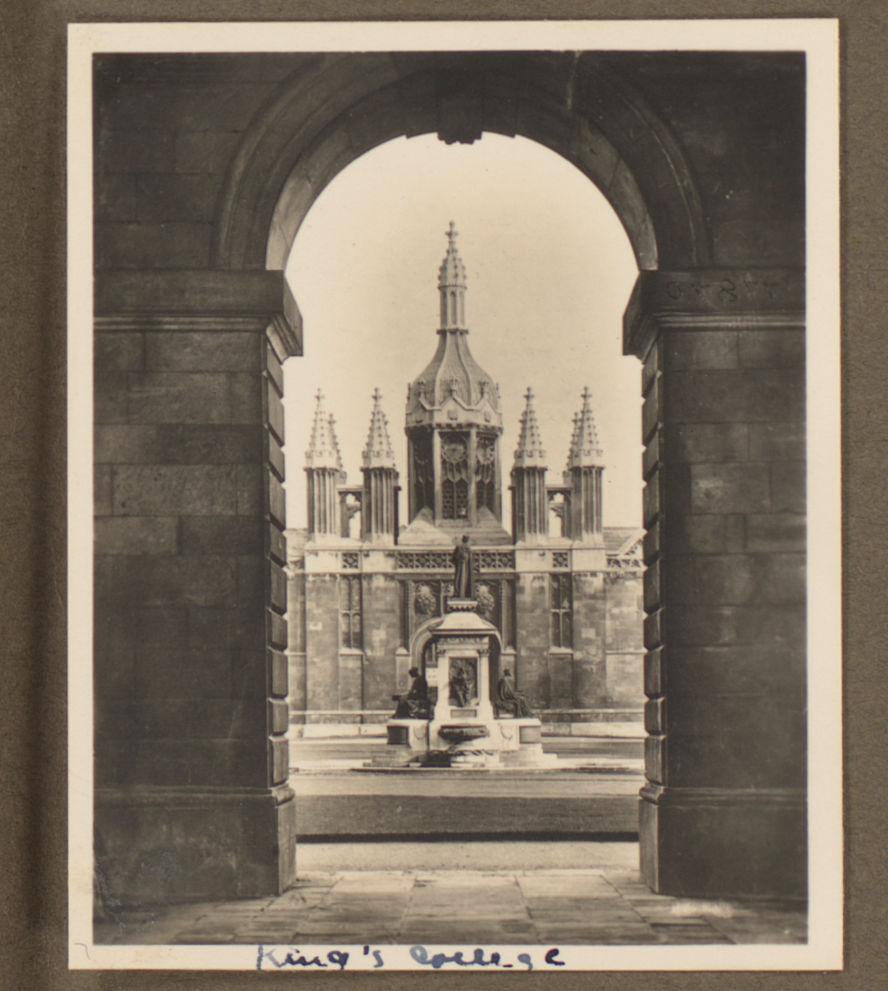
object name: album leaf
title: Binnenplaats van King's College, Cambridge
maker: Anonymous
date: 1932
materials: paper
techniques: gelatin silver print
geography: cambridge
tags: university building, college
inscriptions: inscription: ‘King's College’